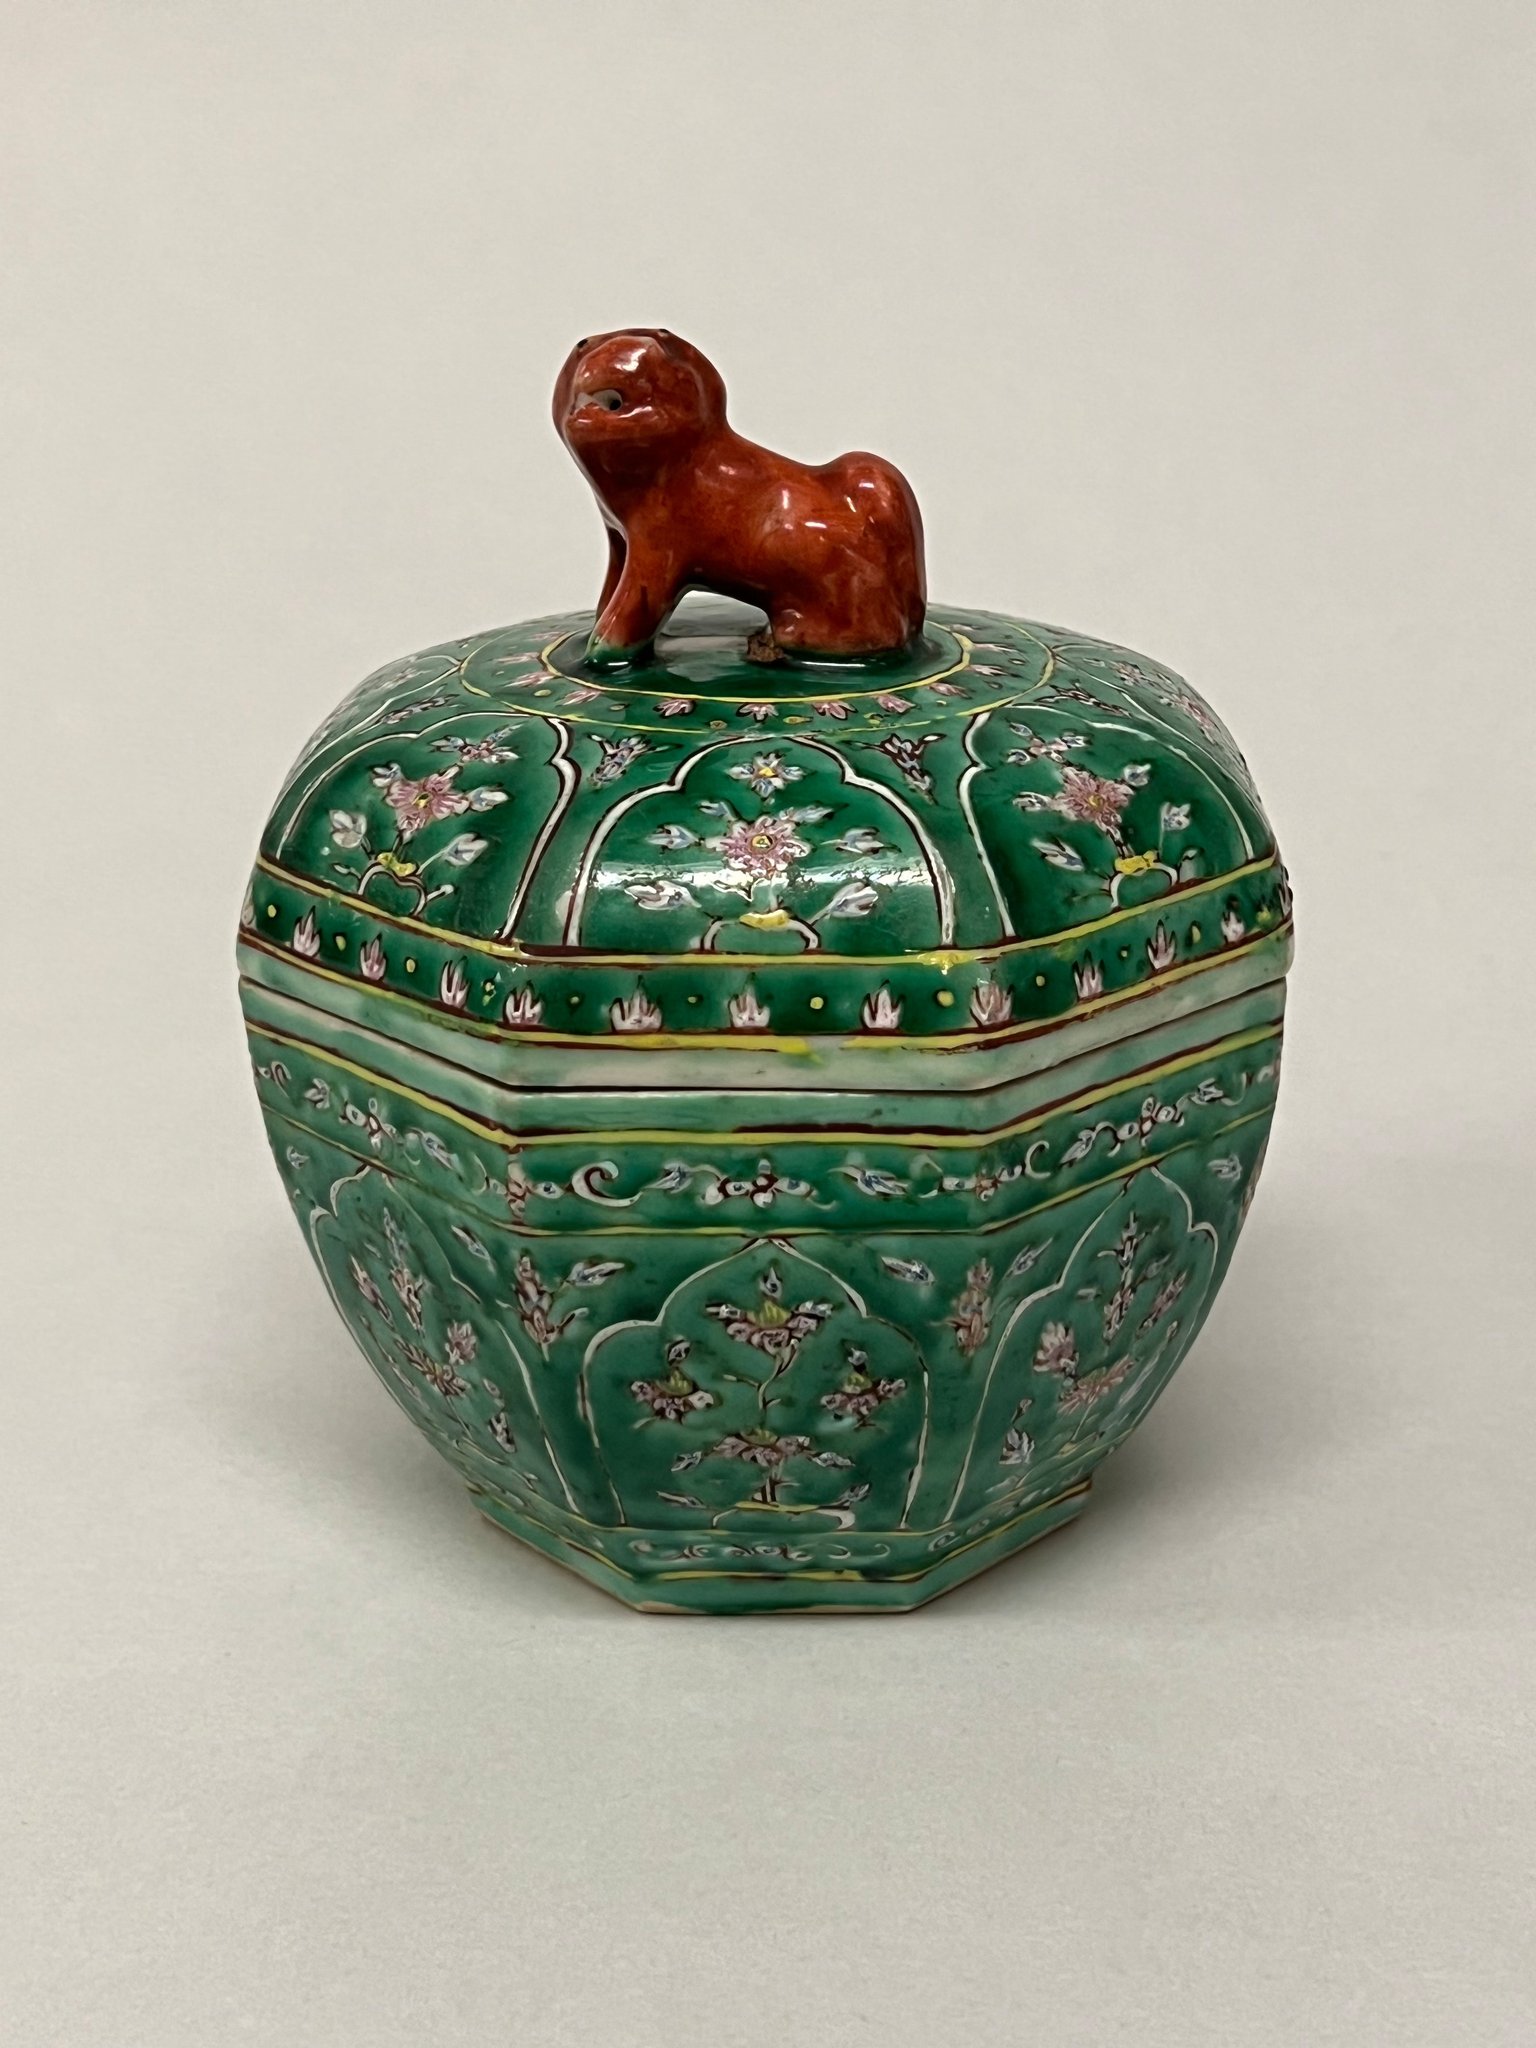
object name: covered bowl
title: Octagonal jar with cover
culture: chinese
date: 1801-1900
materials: enamel, porcelain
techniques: overglaze, painting, polychrome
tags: animals